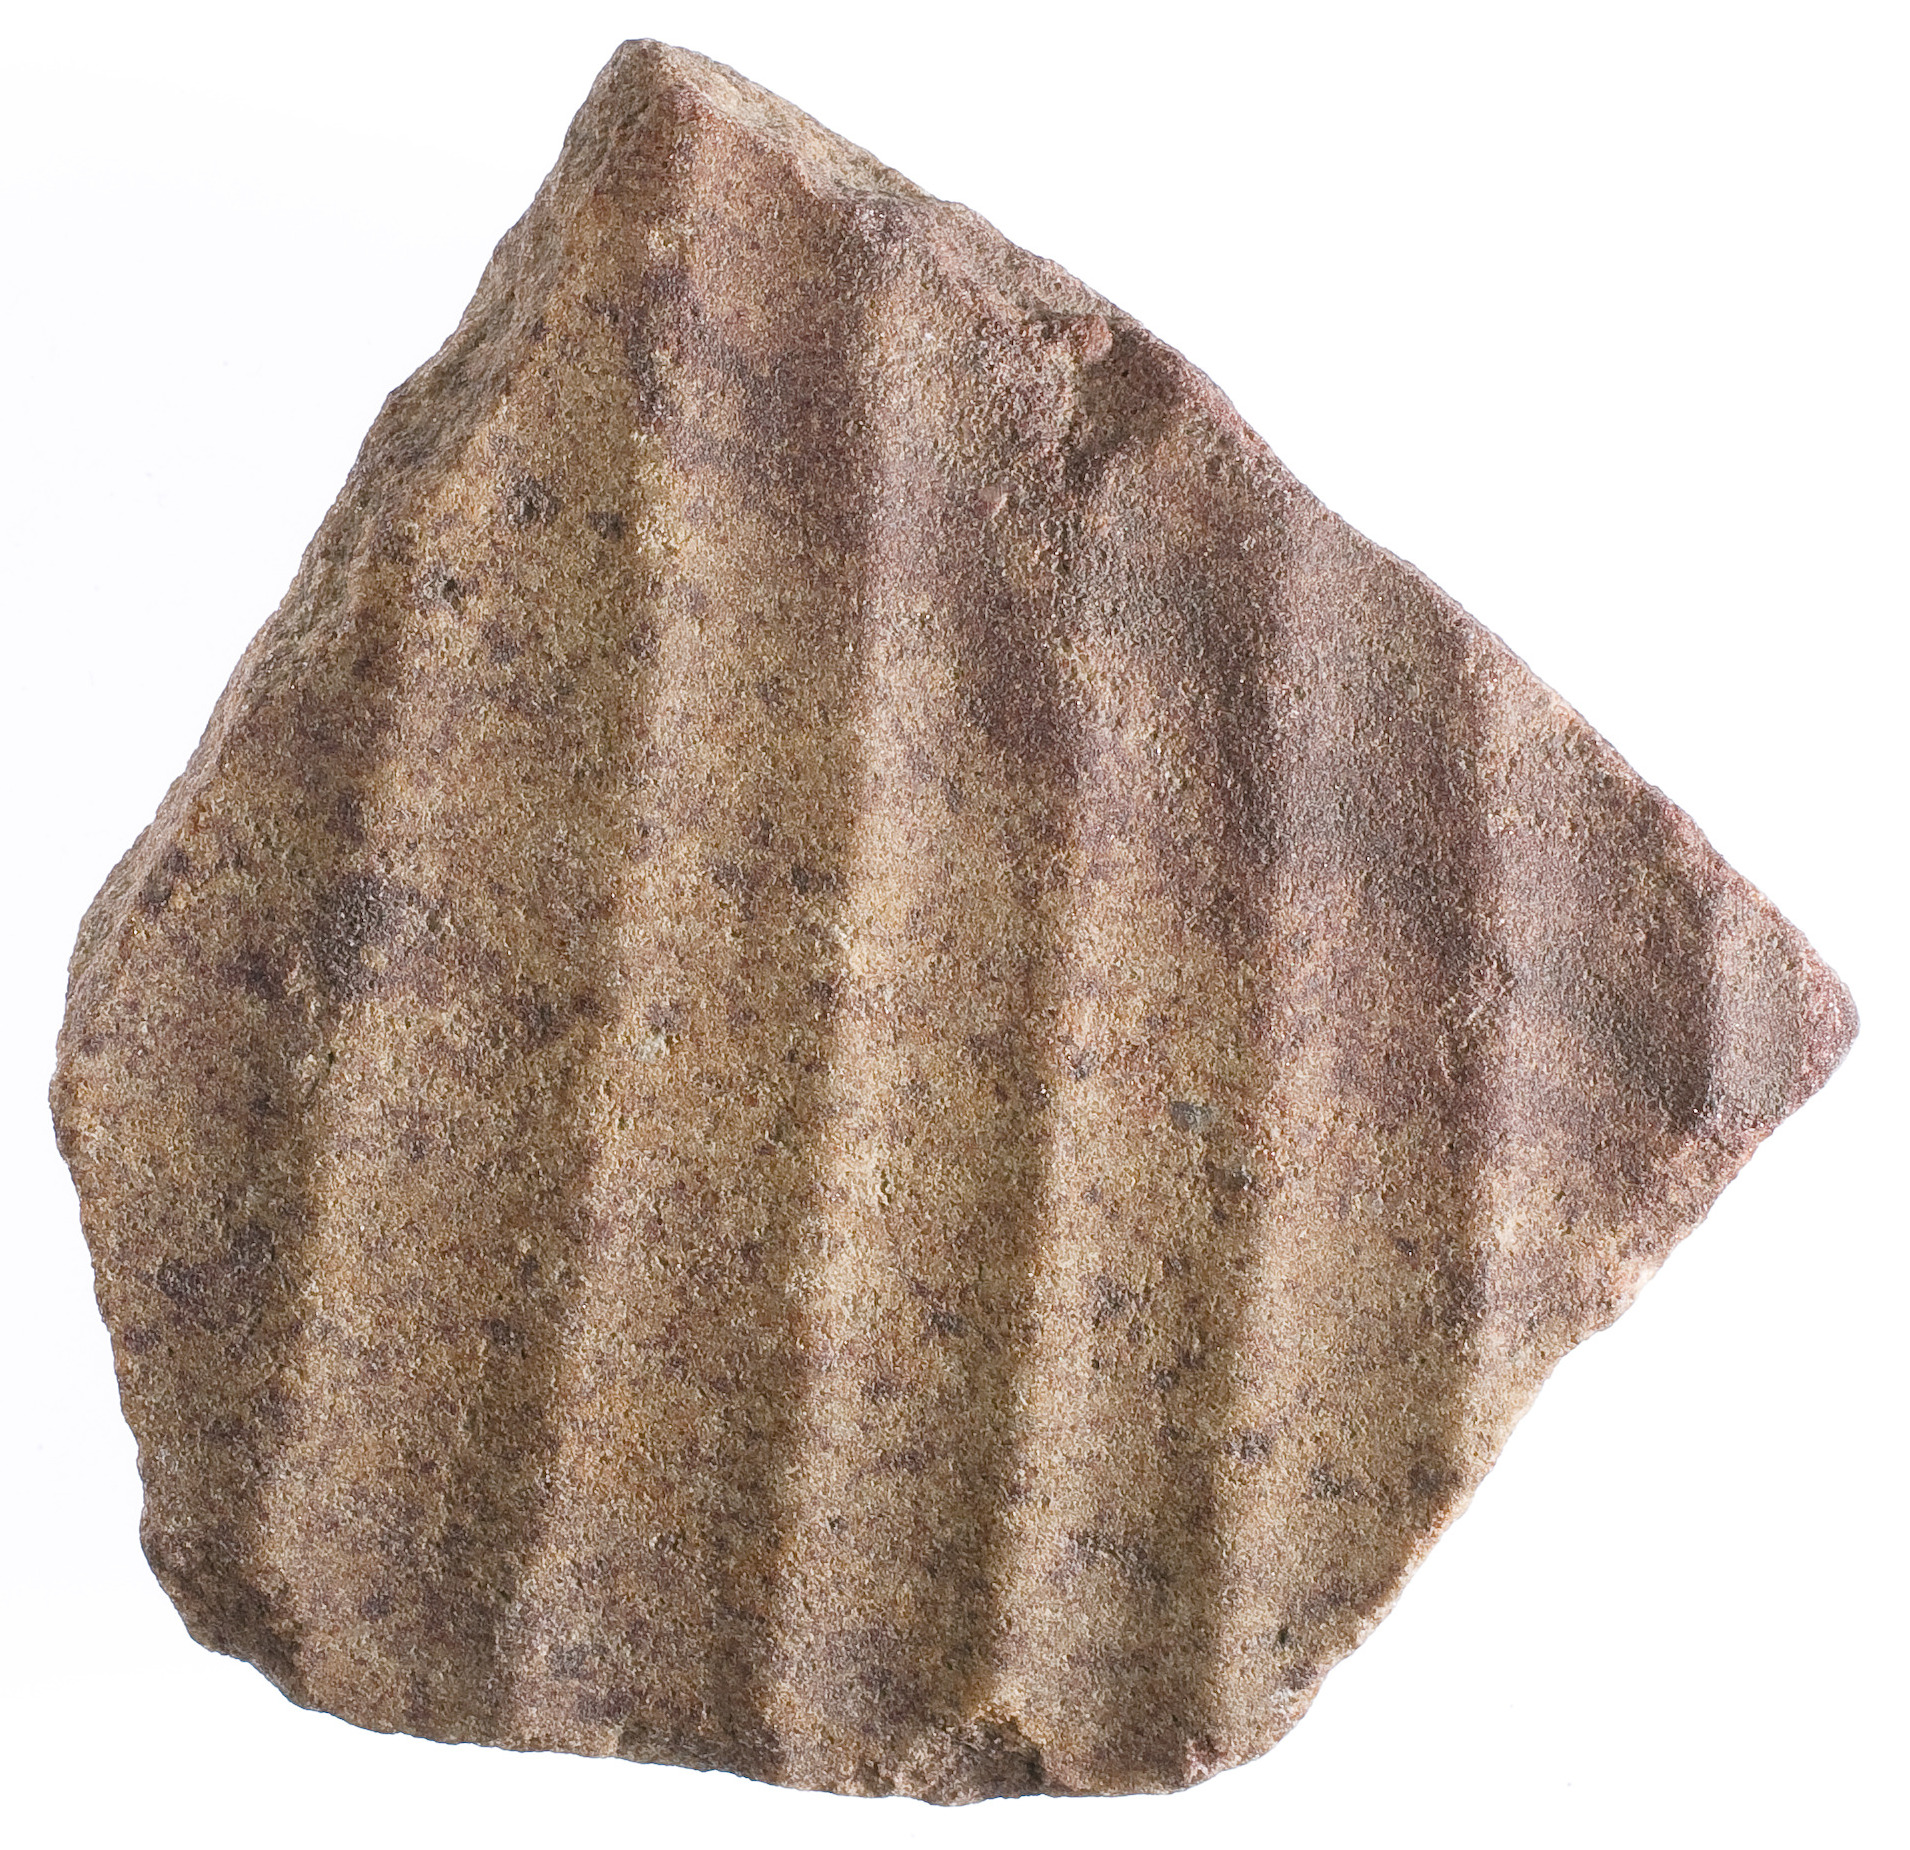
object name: body with garment, pleating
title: body fragment with garment pleats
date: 1353-1336 BCE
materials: quartzite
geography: egypt